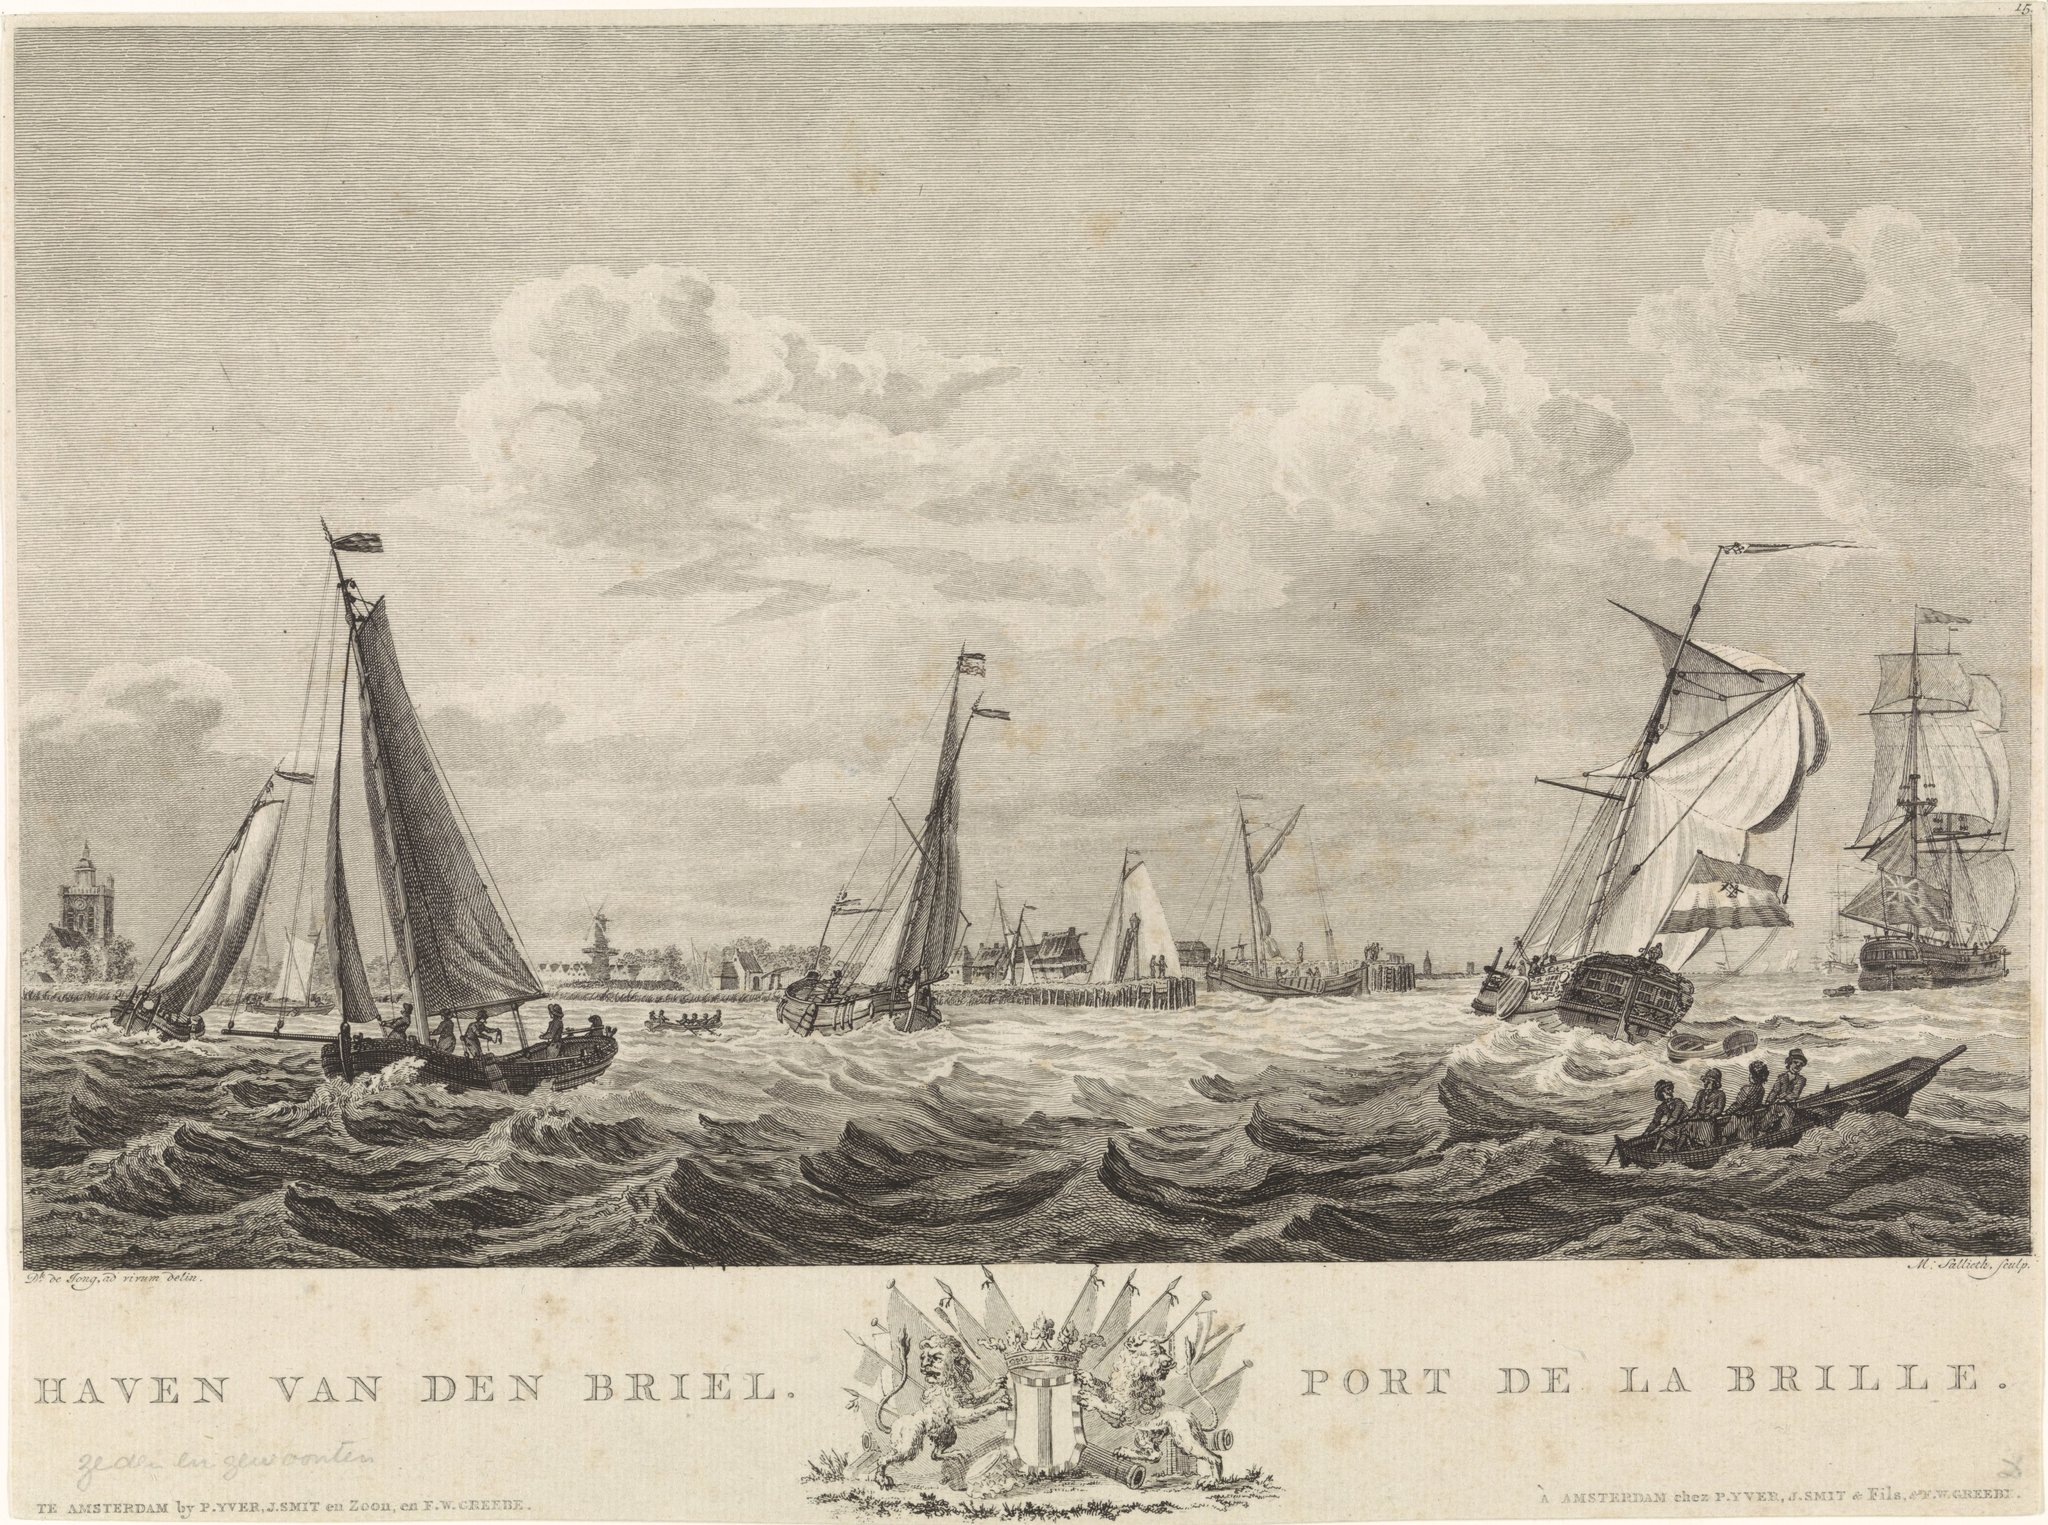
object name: print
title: Haven van Den Briel / Port de La Brille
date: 1779-1787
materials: paper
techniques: etching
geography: amsterdam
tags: harbour, coat of arms (as symbol of the state, etc.) (+ city; municipal), sailing-ship, sailing-boat, brielle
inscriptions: collector's mark: Lugt 2228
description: Zie RP-P-AO-13-58A-1 voor proefdruk. Latere staat ook gebruikt in: Aa, Cornelis van der. Atlas van de zeehavens der Bataafsche Republiek. Met derzelver beschrijvingen in XXXI kunstplaaten / Atlas van de zeehavens der Bataafsche Republiek, die van Batavia en Onrust. Mitsgaders de afbeeldingen van de haringvisscherij en de walvischvangst […]. Amsterdam: Evert Maaskamp, 1805.